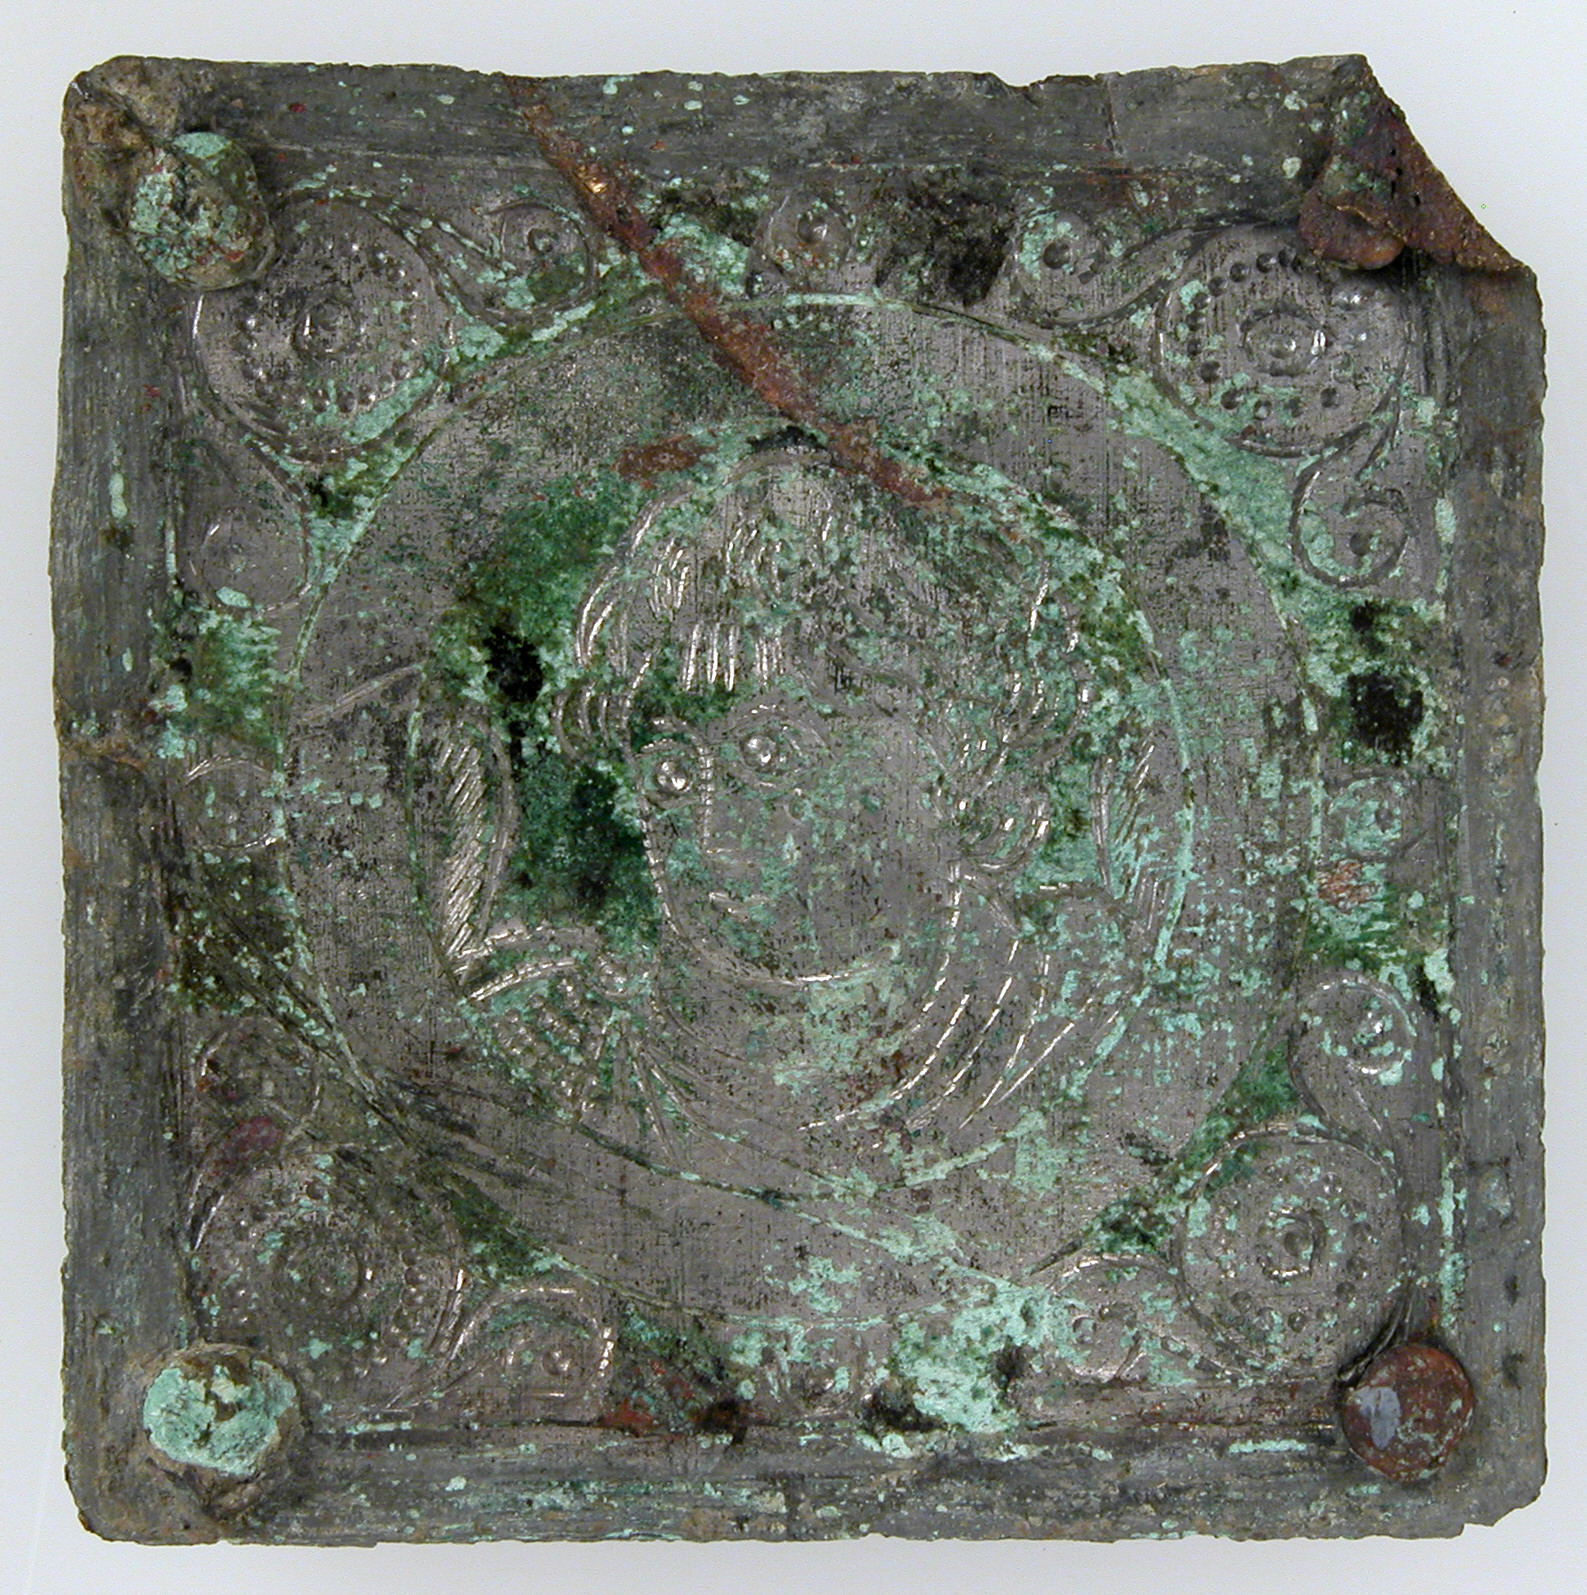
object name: plaque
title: Tinned-Copper Plaque with a Personification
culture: byzantine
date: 350-400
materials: copper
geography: italy